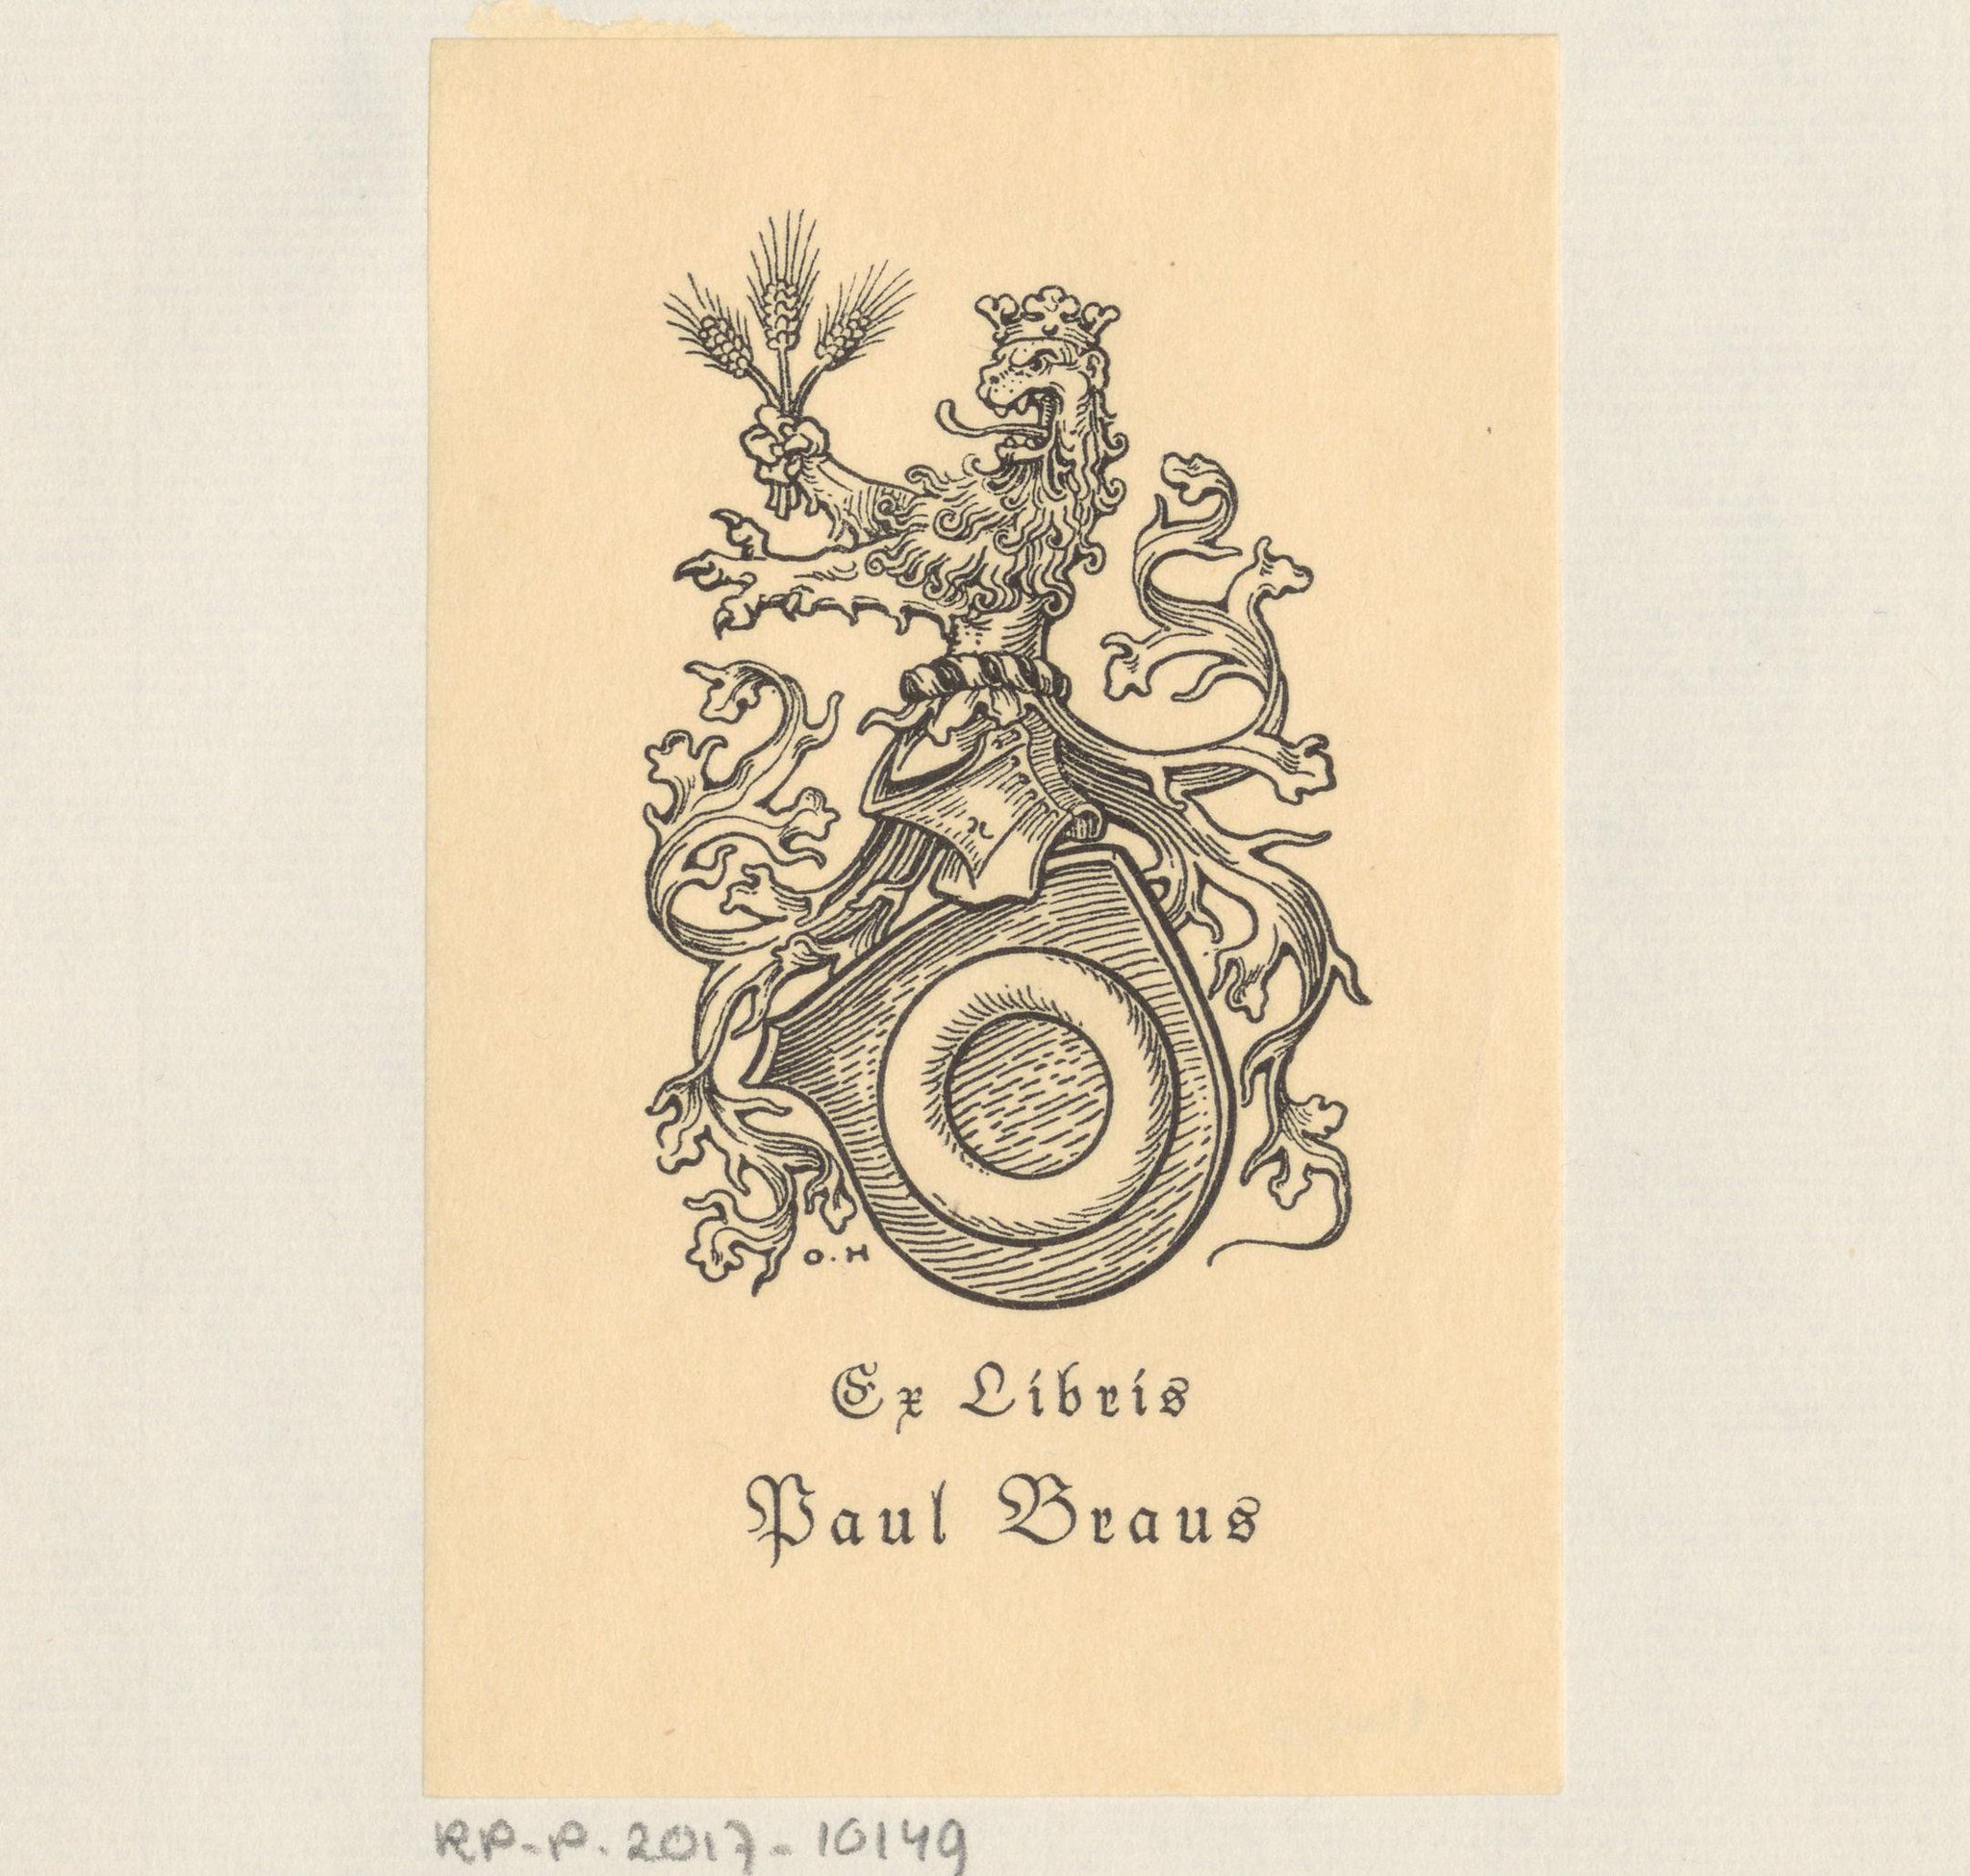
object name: bookplate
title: Ex libris van Paul Braus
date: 1869-1949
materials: paper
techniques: printing block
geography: germany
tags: ear of corn, beasts of prey, predatory animals: lion, armorial bearing, heraldry